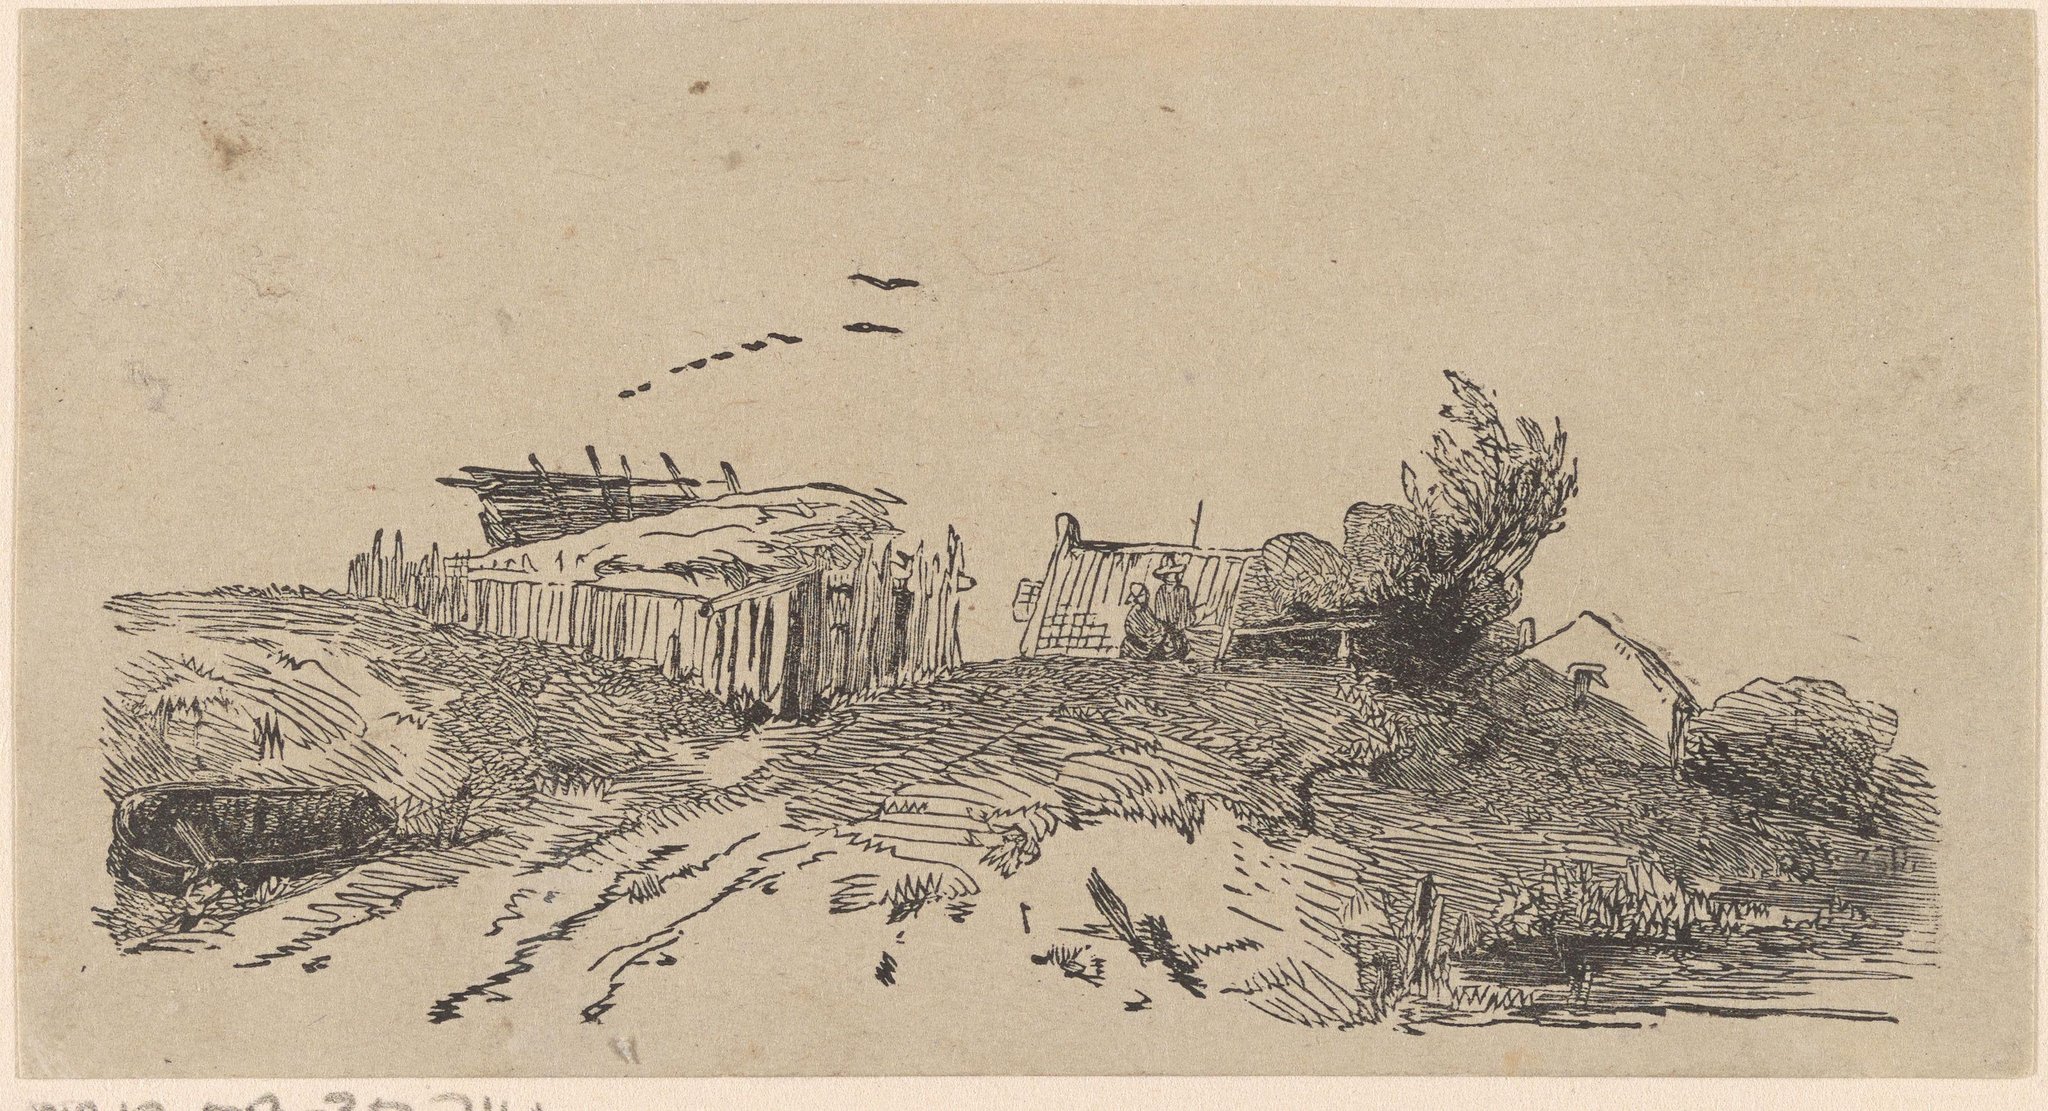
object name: print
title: Rivierlandschap met een aantal huizen, twee figuren en een boot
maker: isaac weissenbruch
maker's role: print maker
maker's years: 1826-1912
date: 1836-1912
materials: paper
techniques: engraving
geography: netherlands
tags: rowing-boat, canoe, etc., river (+ landscape with figures, staffage), farm or solitary house in landscape